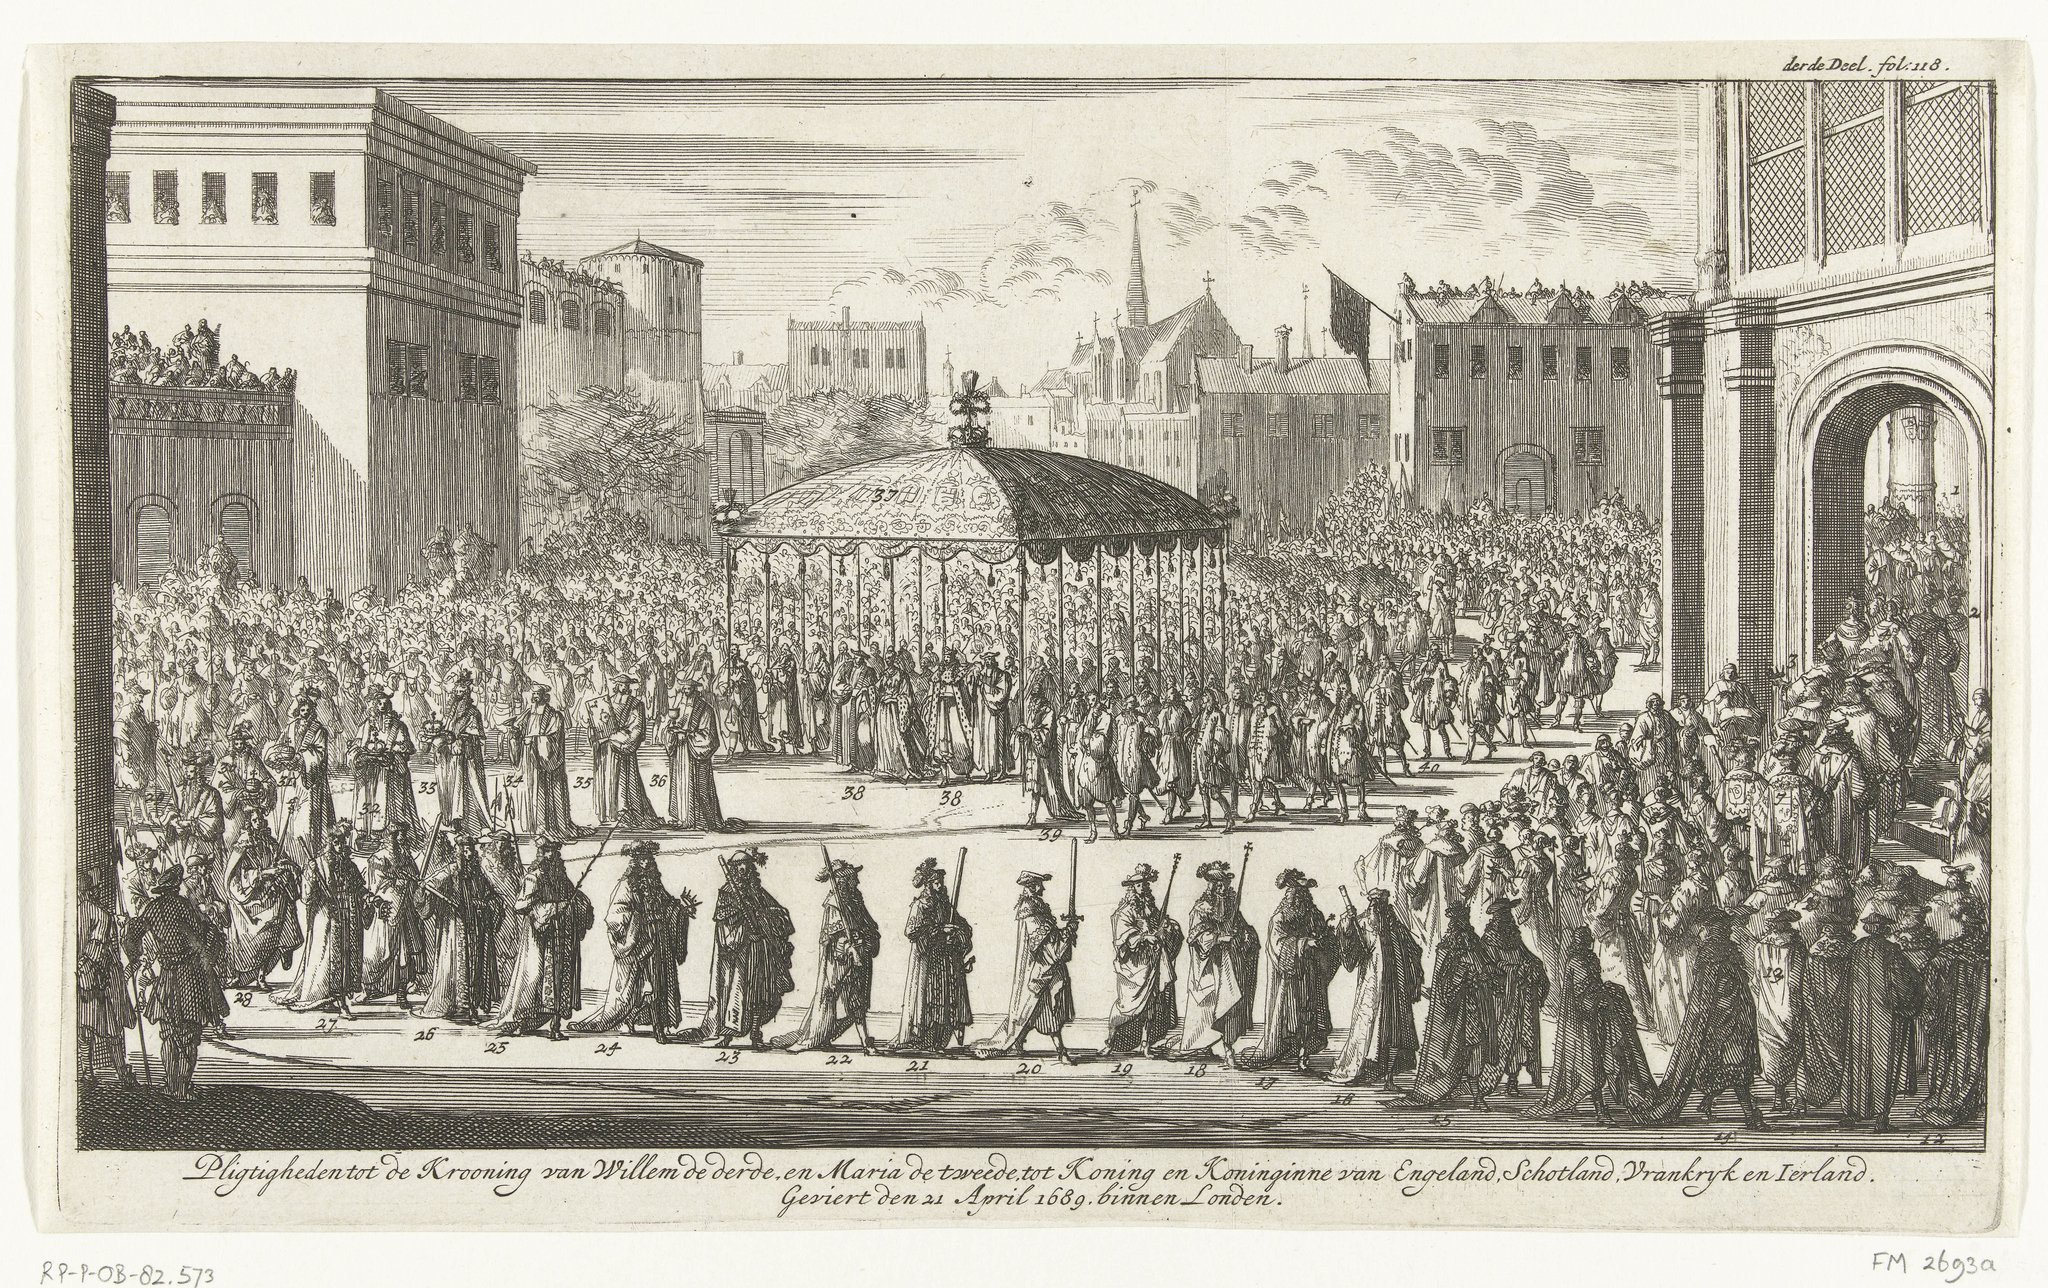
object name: print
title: Kroningsoptocht van Willem III, 1689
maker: jan luyken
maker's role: draughtsman, print maker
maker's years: 1649-1712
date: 1689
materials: paper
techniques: etching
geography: northern netherlands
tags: the hague, william iii (prince of orange and king of england, scotland, and ireland), london, maria ii stuart (koningin van engeland, schotland en ierland), coronation procession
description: Optocht naar de kroningsceremonie, 21 april 1689. Willem en Mary onder een baldakijn in een lange stoet onderweg naar Westminster Abbey. Met cijfers in de voorstelling en gemerkt rechtsboven: derde Deel. fol. 118.